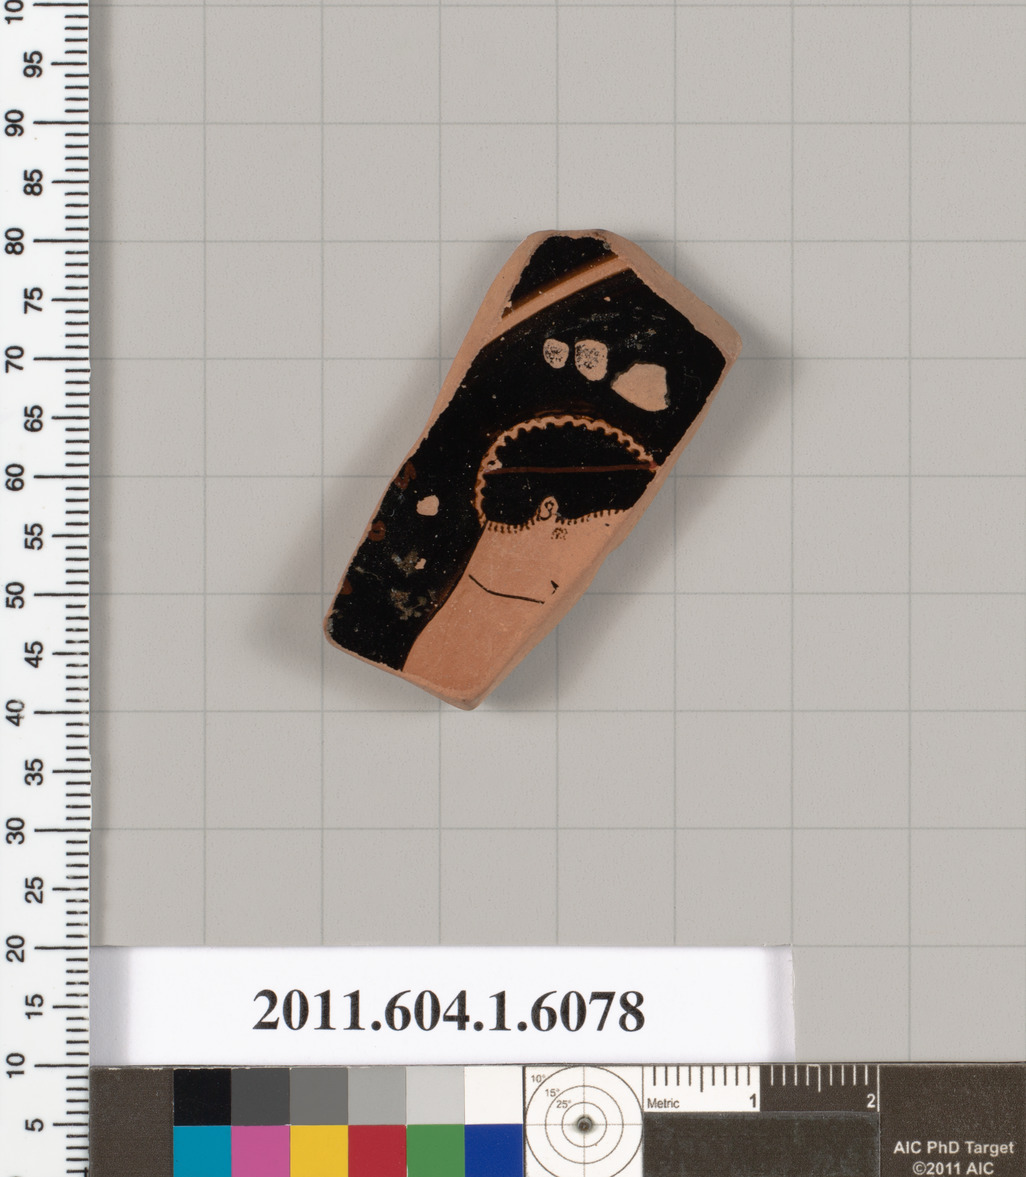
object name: kylix fragment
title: Terracotta fragment of a kylix (drinking cup)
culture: greek, attic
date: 500-490 BCE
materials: terracotta